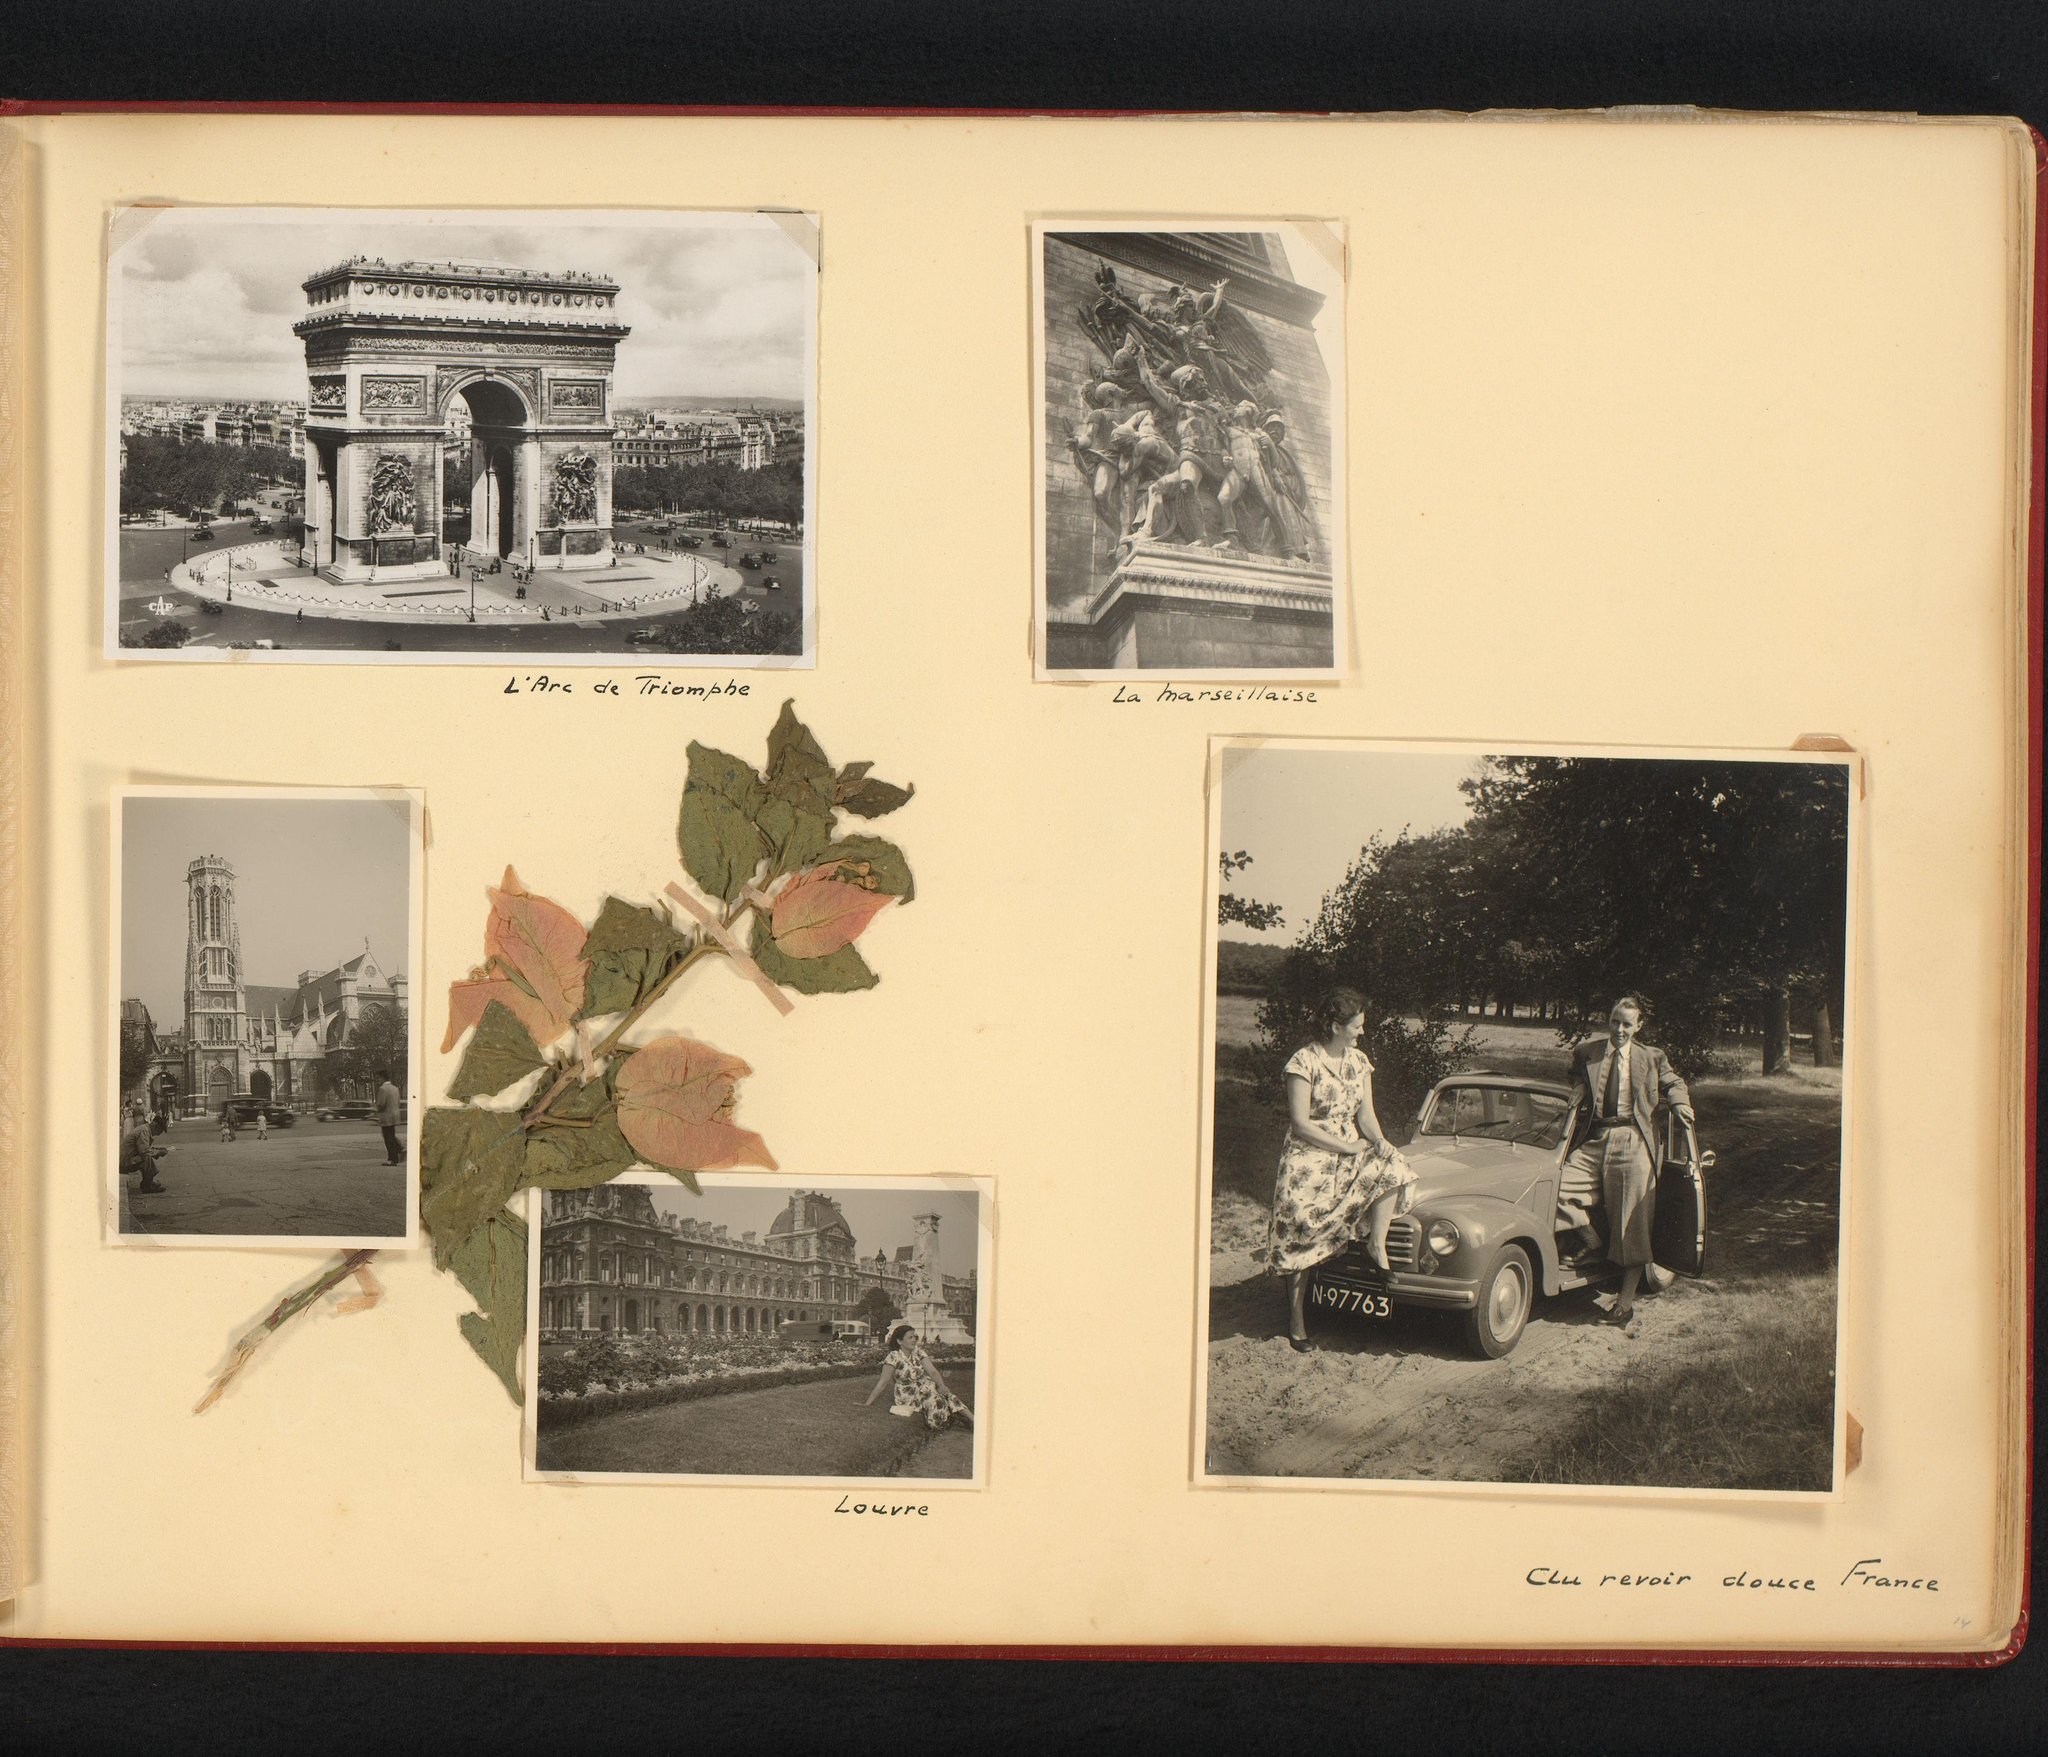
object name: photograph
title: Parijs en gedroogde bloem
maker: Anonymous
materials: paper, photographic support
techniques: gelatin silver print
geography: france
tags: the family travelling, on holiday, flowers: bougainvillea, outing, pleasure trip, automobile, city-view in general; 'veduta' (+ city(-scape) with figures, staffage), paris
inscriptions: date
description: Albumblad met vier foto's van gezichten te Parijs en een vijfde foto van het echtpaar bij hun auto met de tekst 'Au revoir douce France'. Met gedroogde bloementakje, waarschijnlijk Bougainvillea. Herinnering aan een vakantiereis door Frankrijk van 23 augustus tot 9 september 1951. Onderdeel van het fotoalbum 'Met de Fiat 500 cabriolet op vakantie' met foto's van vakanties van een gezin tussen 1951-1959.